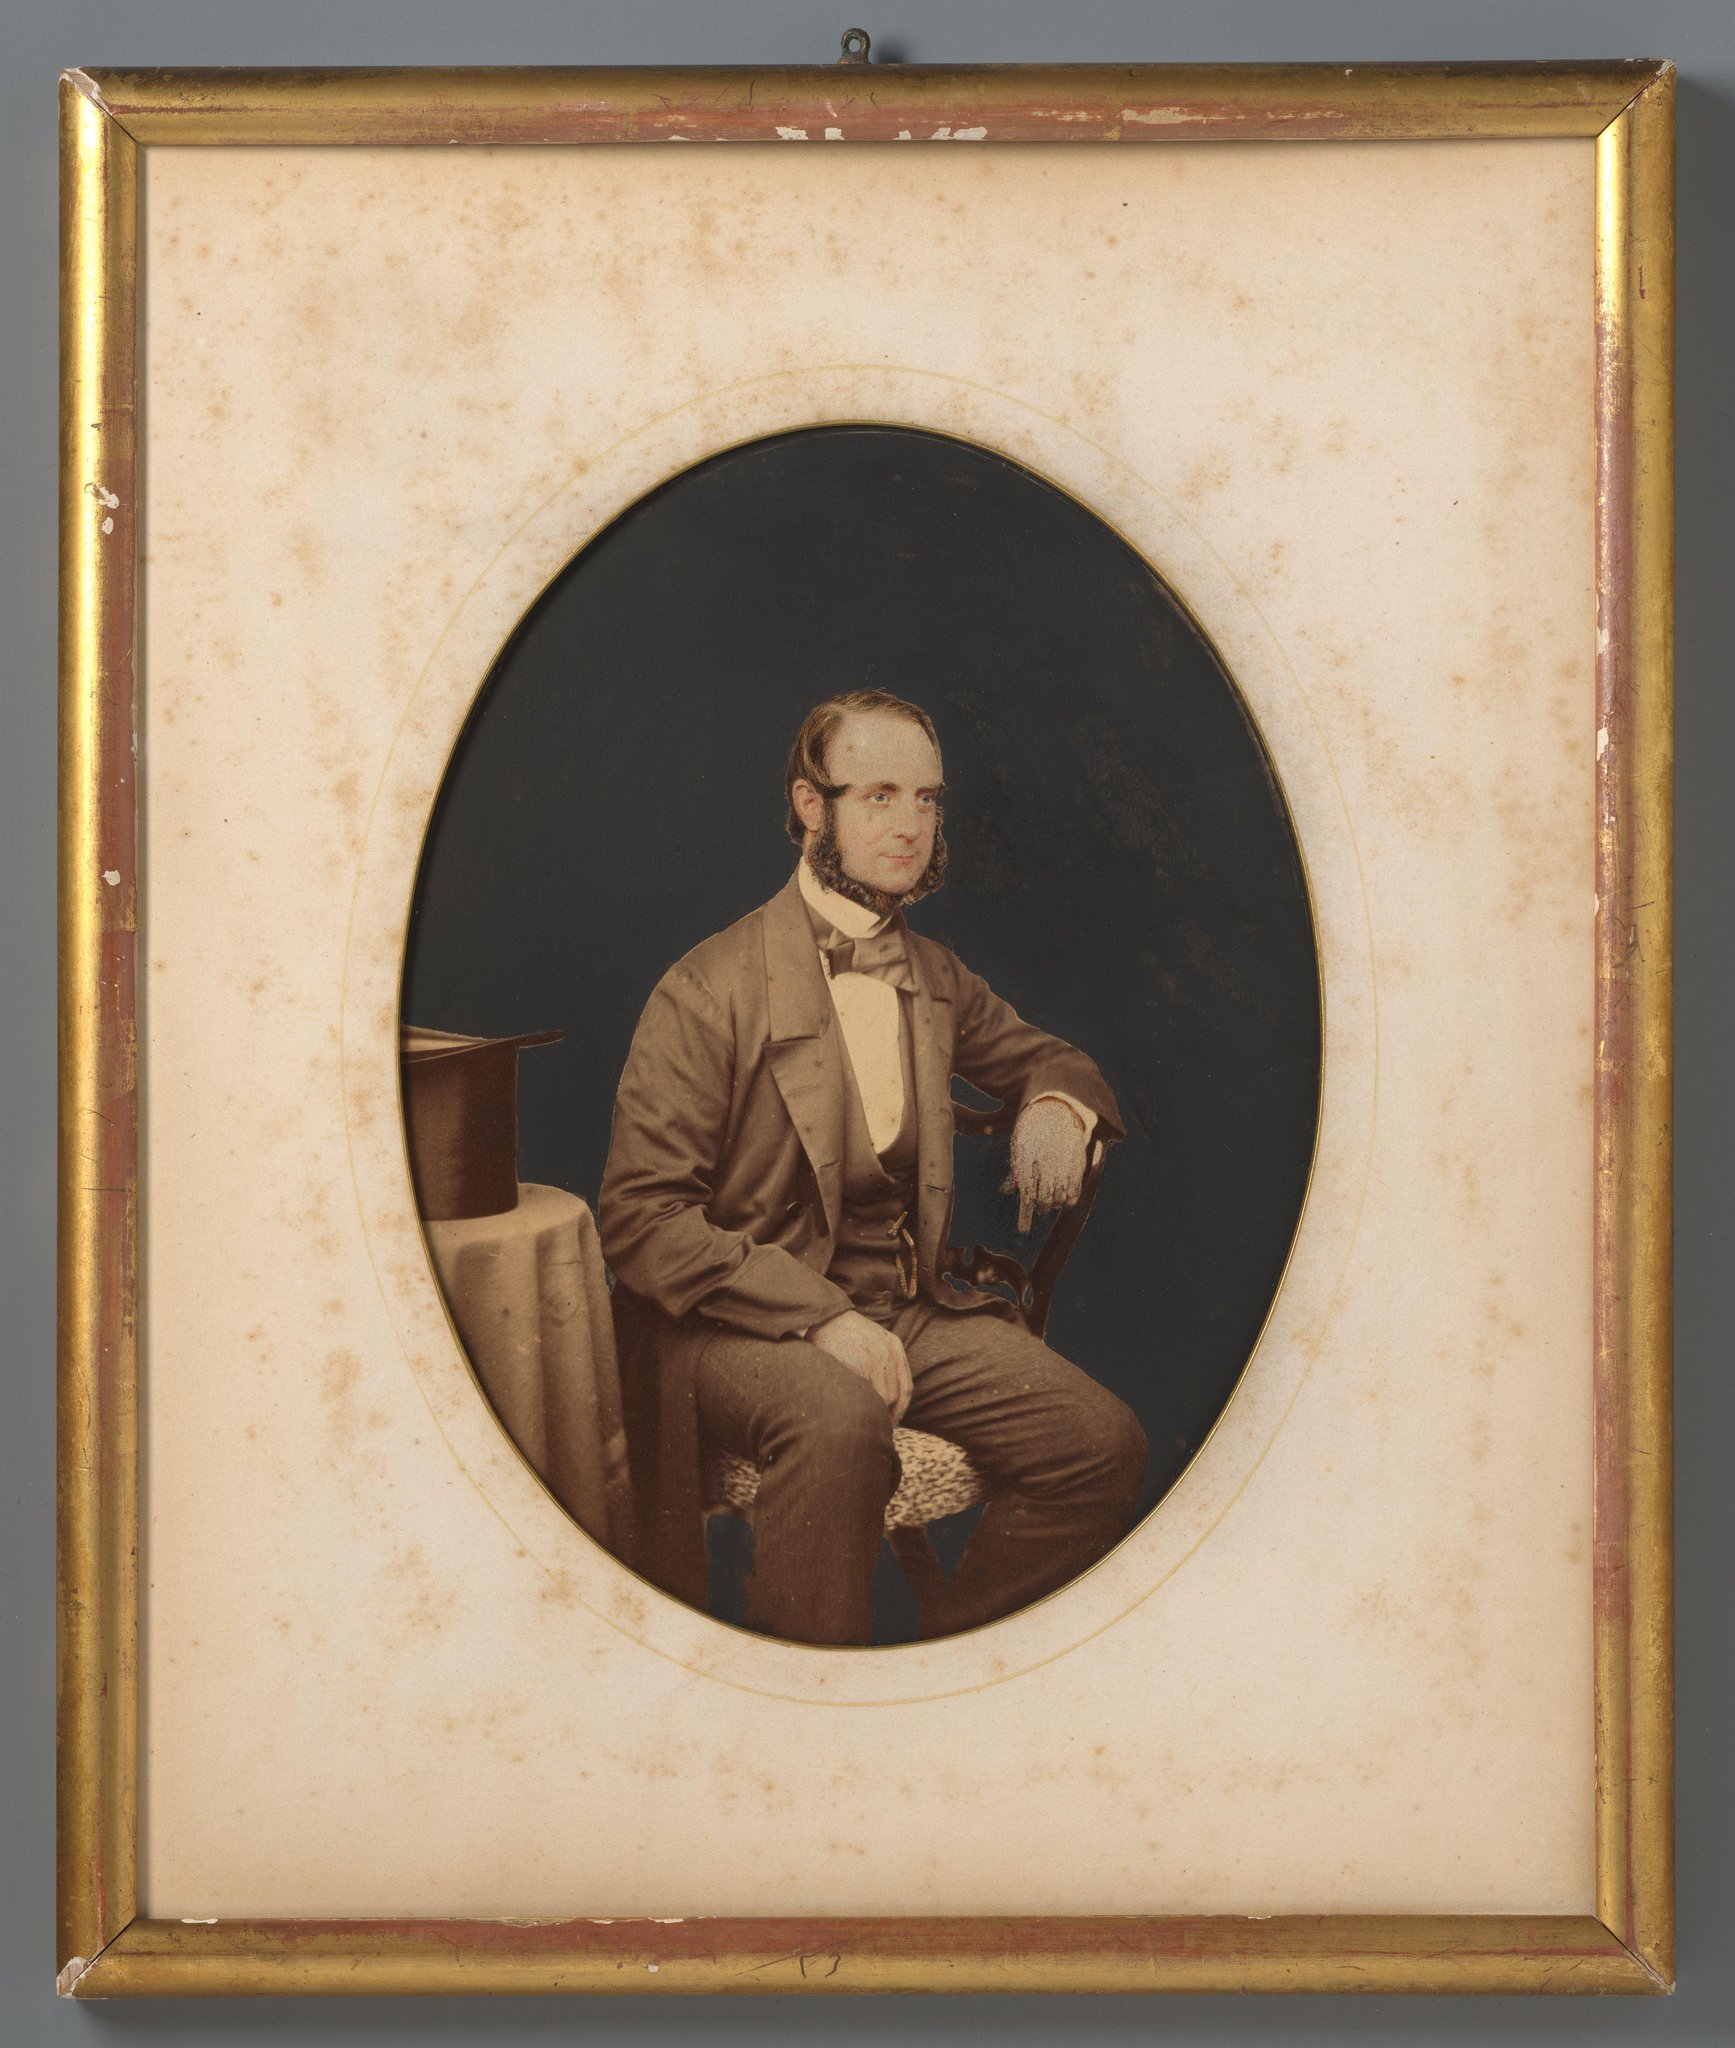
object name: photograph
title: Portret van een man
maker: h. vines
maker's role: fotograaf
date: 1858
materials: cardboard, ink, paper, wood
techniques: albumen print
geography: clifton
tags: historical persons not known by name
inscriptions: address: ‘No. [in pen ingevuld ‘5927’] // THIS PHOTOGRAPH WAS TAKEN, // [in pen ingevuld ‘August 3rd, 1858,’] // AT THE // PHOTOGRAPHIC INSTITUTION, // QUEEN’s ROAD, CLIFTON. // OPEN FROM 10 TILL 4. // PROPRIETOR // MR. H. VINES.// […]’, annotation: ‘Face [onleesbaar] bold // Hair very dark Brown // Whiskers Black // Colour moderate // Eyes Greenish Grey’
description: Portret van een man in passepartout en lijst.